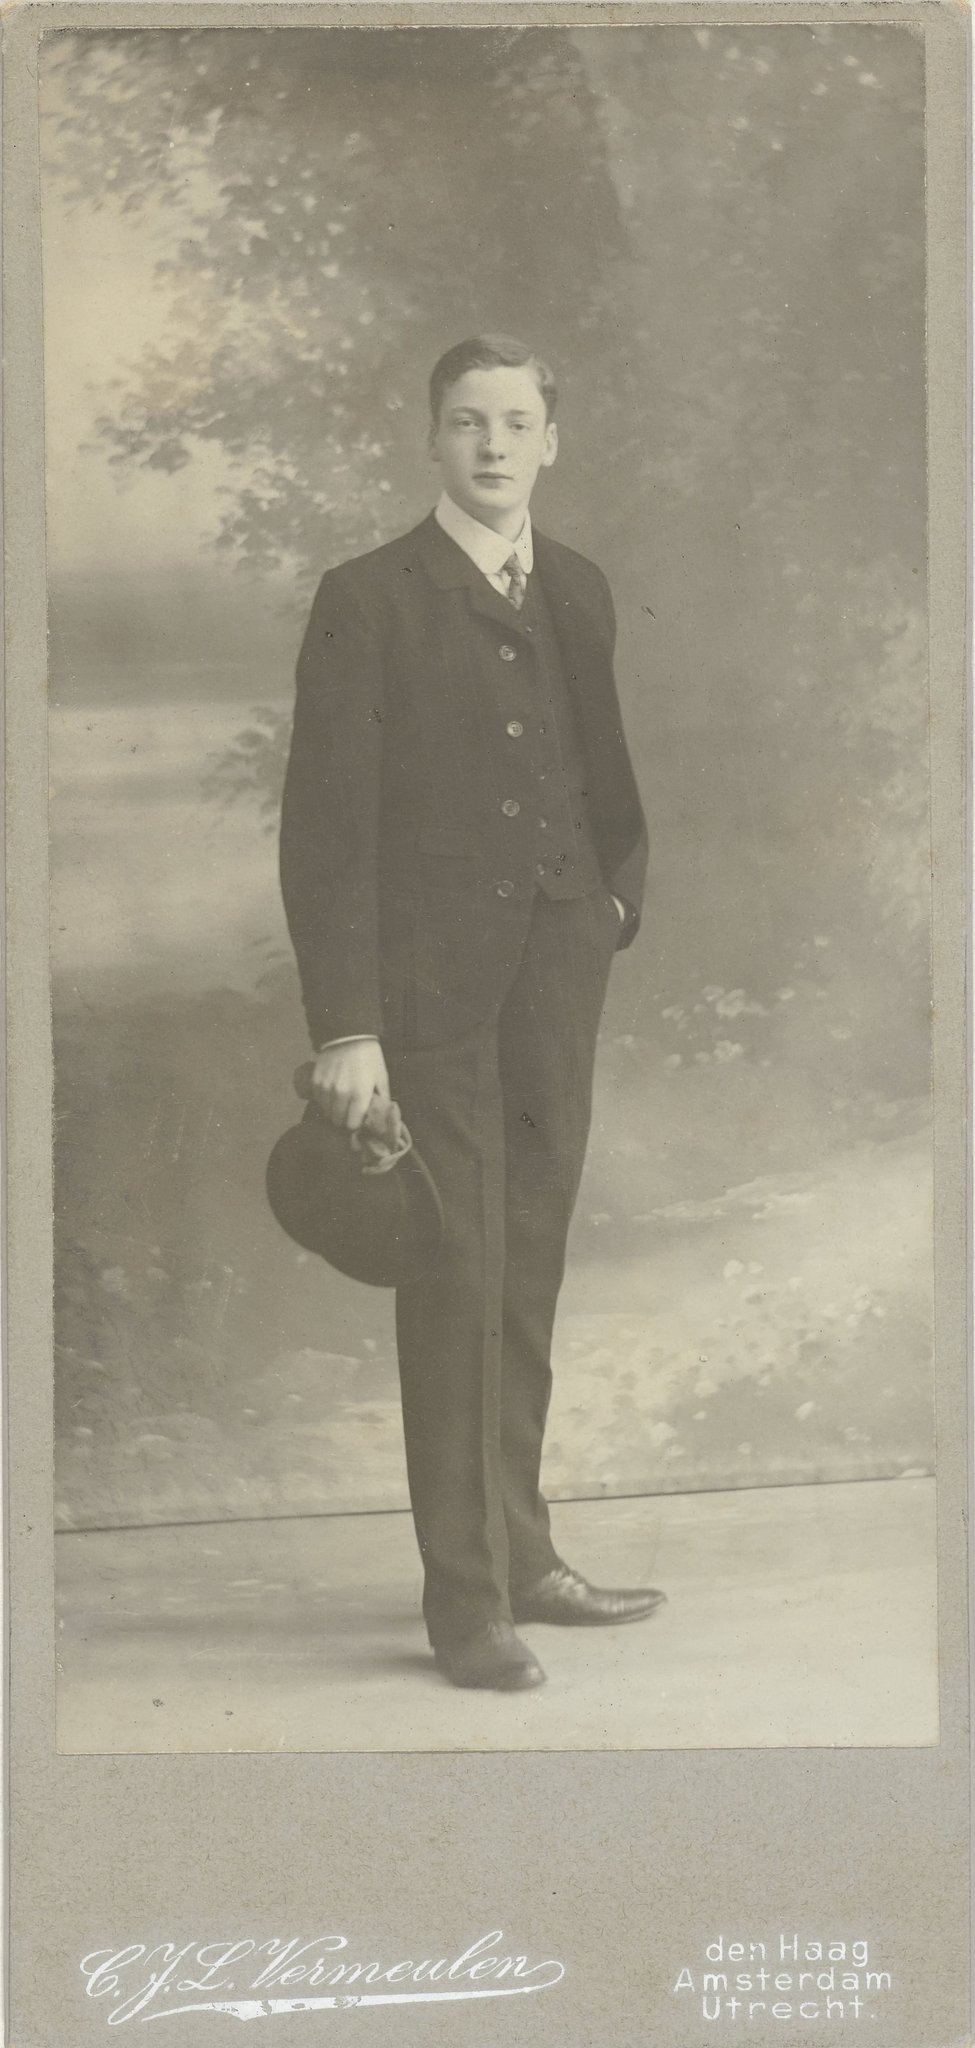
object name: photograph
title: Studioportret van David Vermeulen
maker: cornelis johannes lodewicus vermeulen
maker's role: fotograaf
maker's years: 1861-1936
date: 1918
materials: cardboard, photographic support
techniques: albumen print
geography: amsterdam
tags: amsterdam